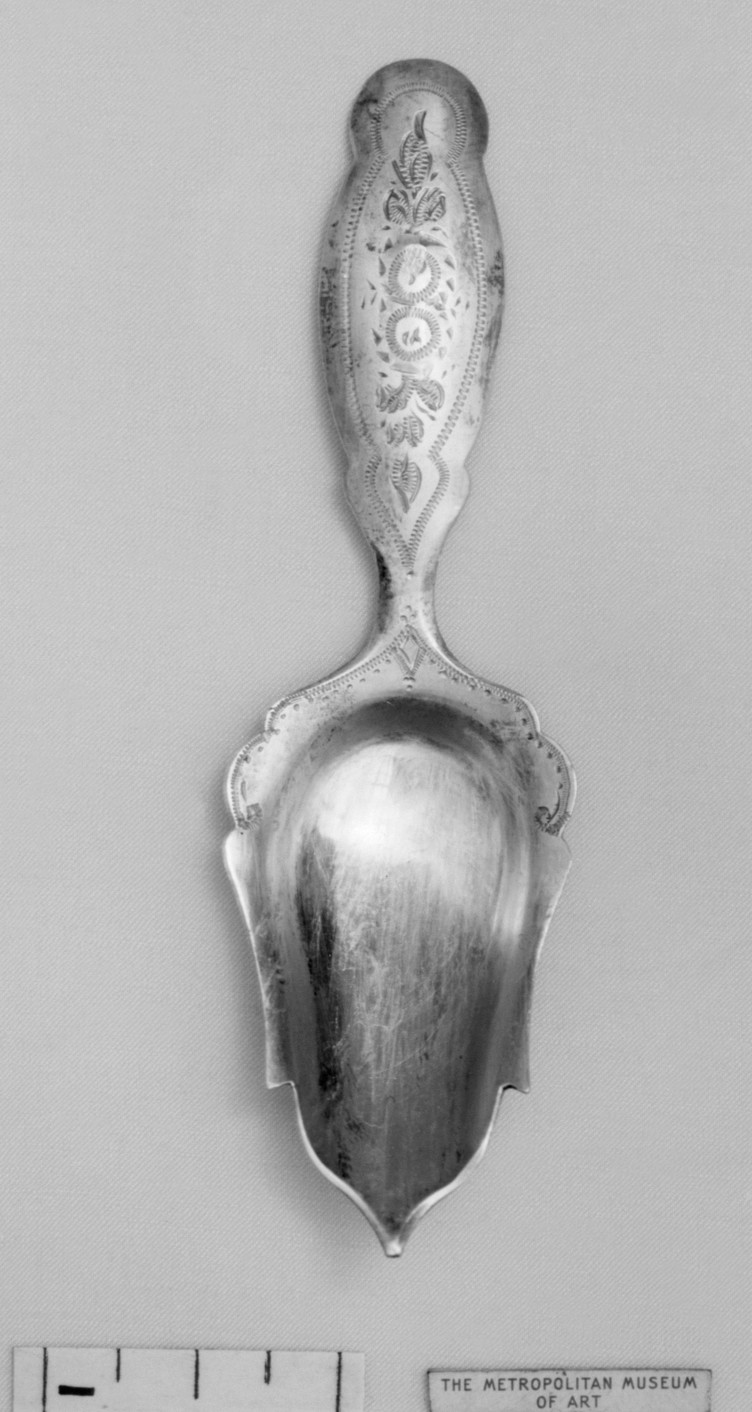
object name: caddy spoon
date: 1801-1900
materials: silver